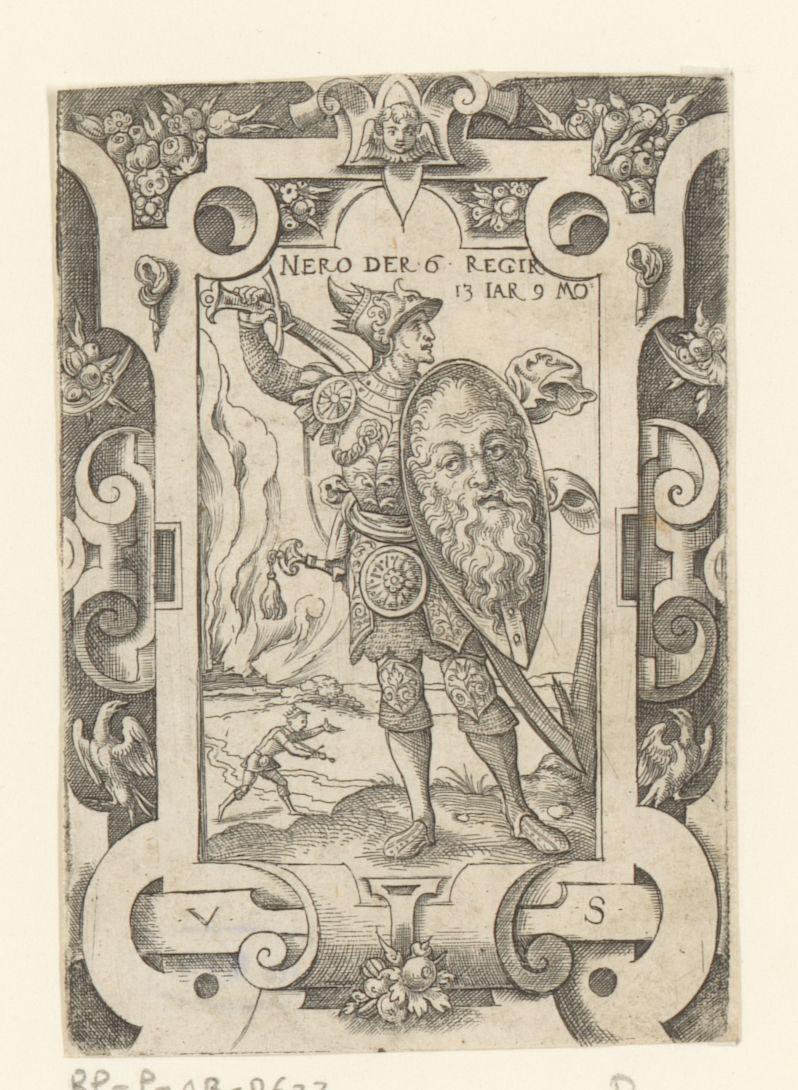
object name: print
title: Keizer Nero in rolwerk omlijsting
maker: virgilius solis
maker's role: draughtsman, print maker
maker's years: 1514-1562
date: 1524-1562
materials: paper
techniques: engraving, etching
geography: nuremberg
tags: (story of) nero, the roman emperor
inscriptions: collector's mark: Lugt 2228, number: ‘125’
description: Deze prent maakt deel uit van een serie bestaande uit twaalf prenten met de eerste Romeinse keizers staand in rolwerk omlijstingen. In de collectie van het Rijksmuseum bevinden zich elf van de twaalf prenten.